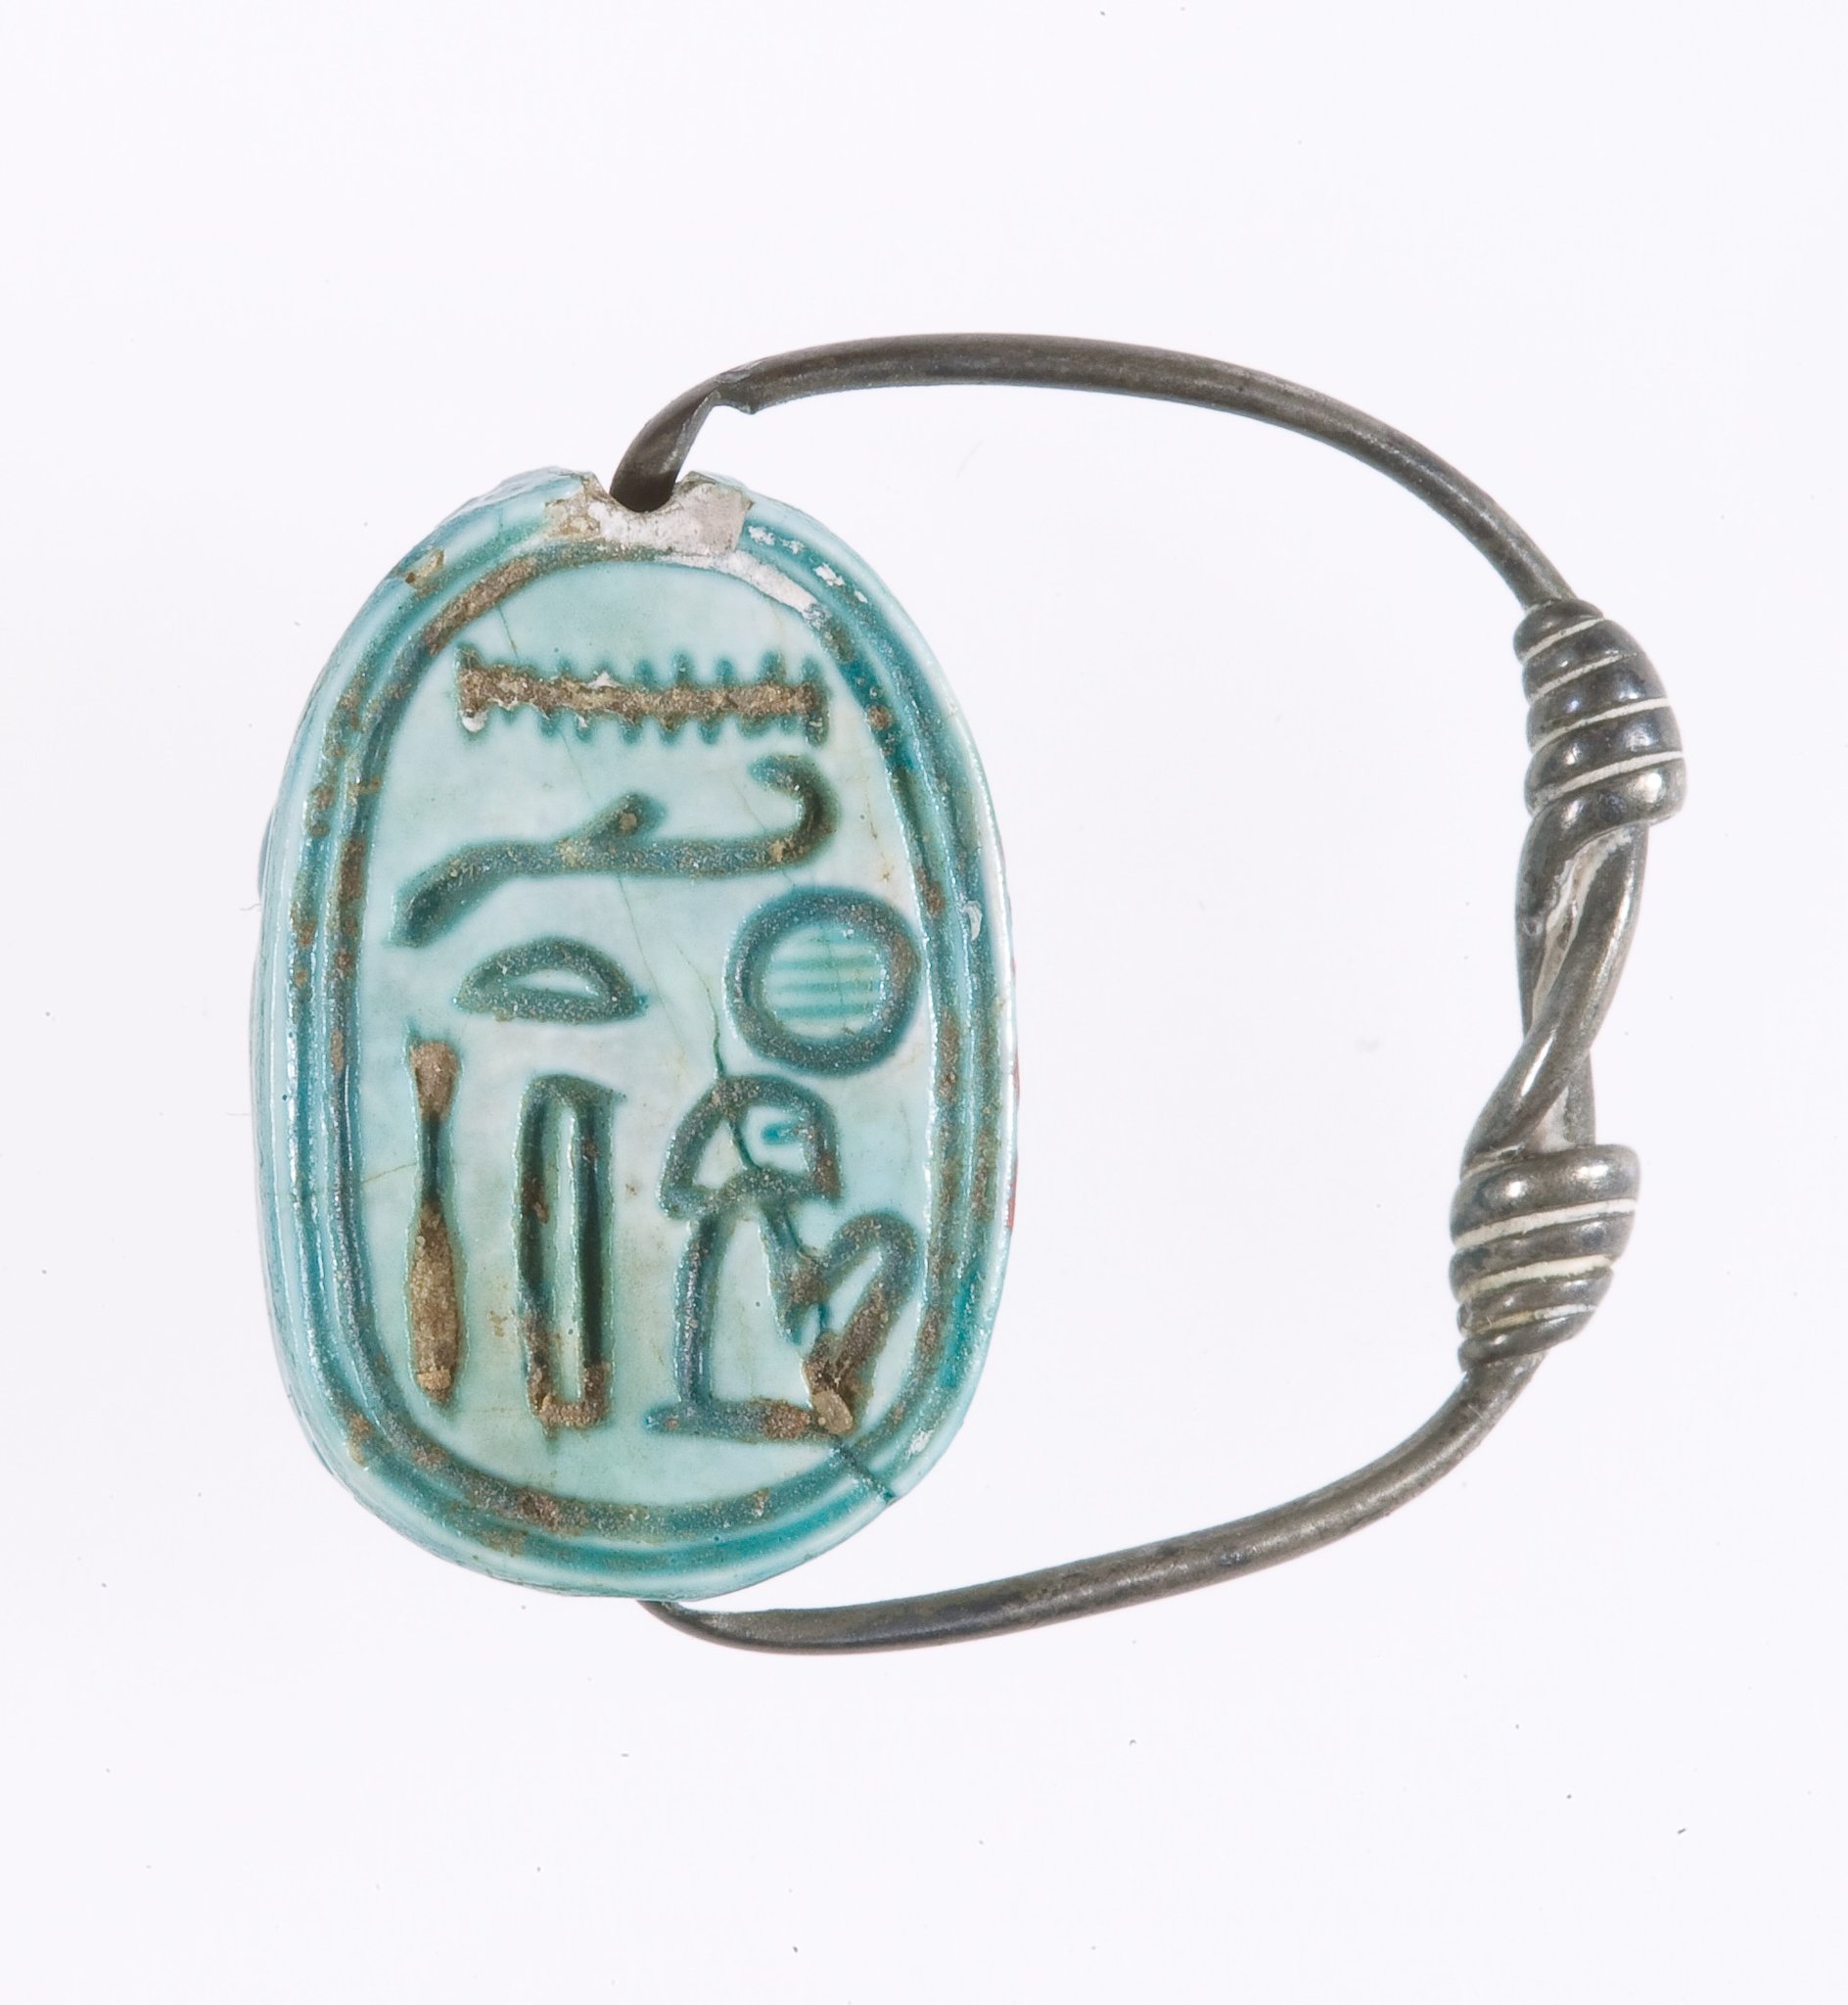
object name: ring, scarab, nakht justified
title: Scarab Finger Ring Inscribed for Nakht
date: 1640-1550 BCE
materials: silver, stone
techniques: glazing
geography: egypt